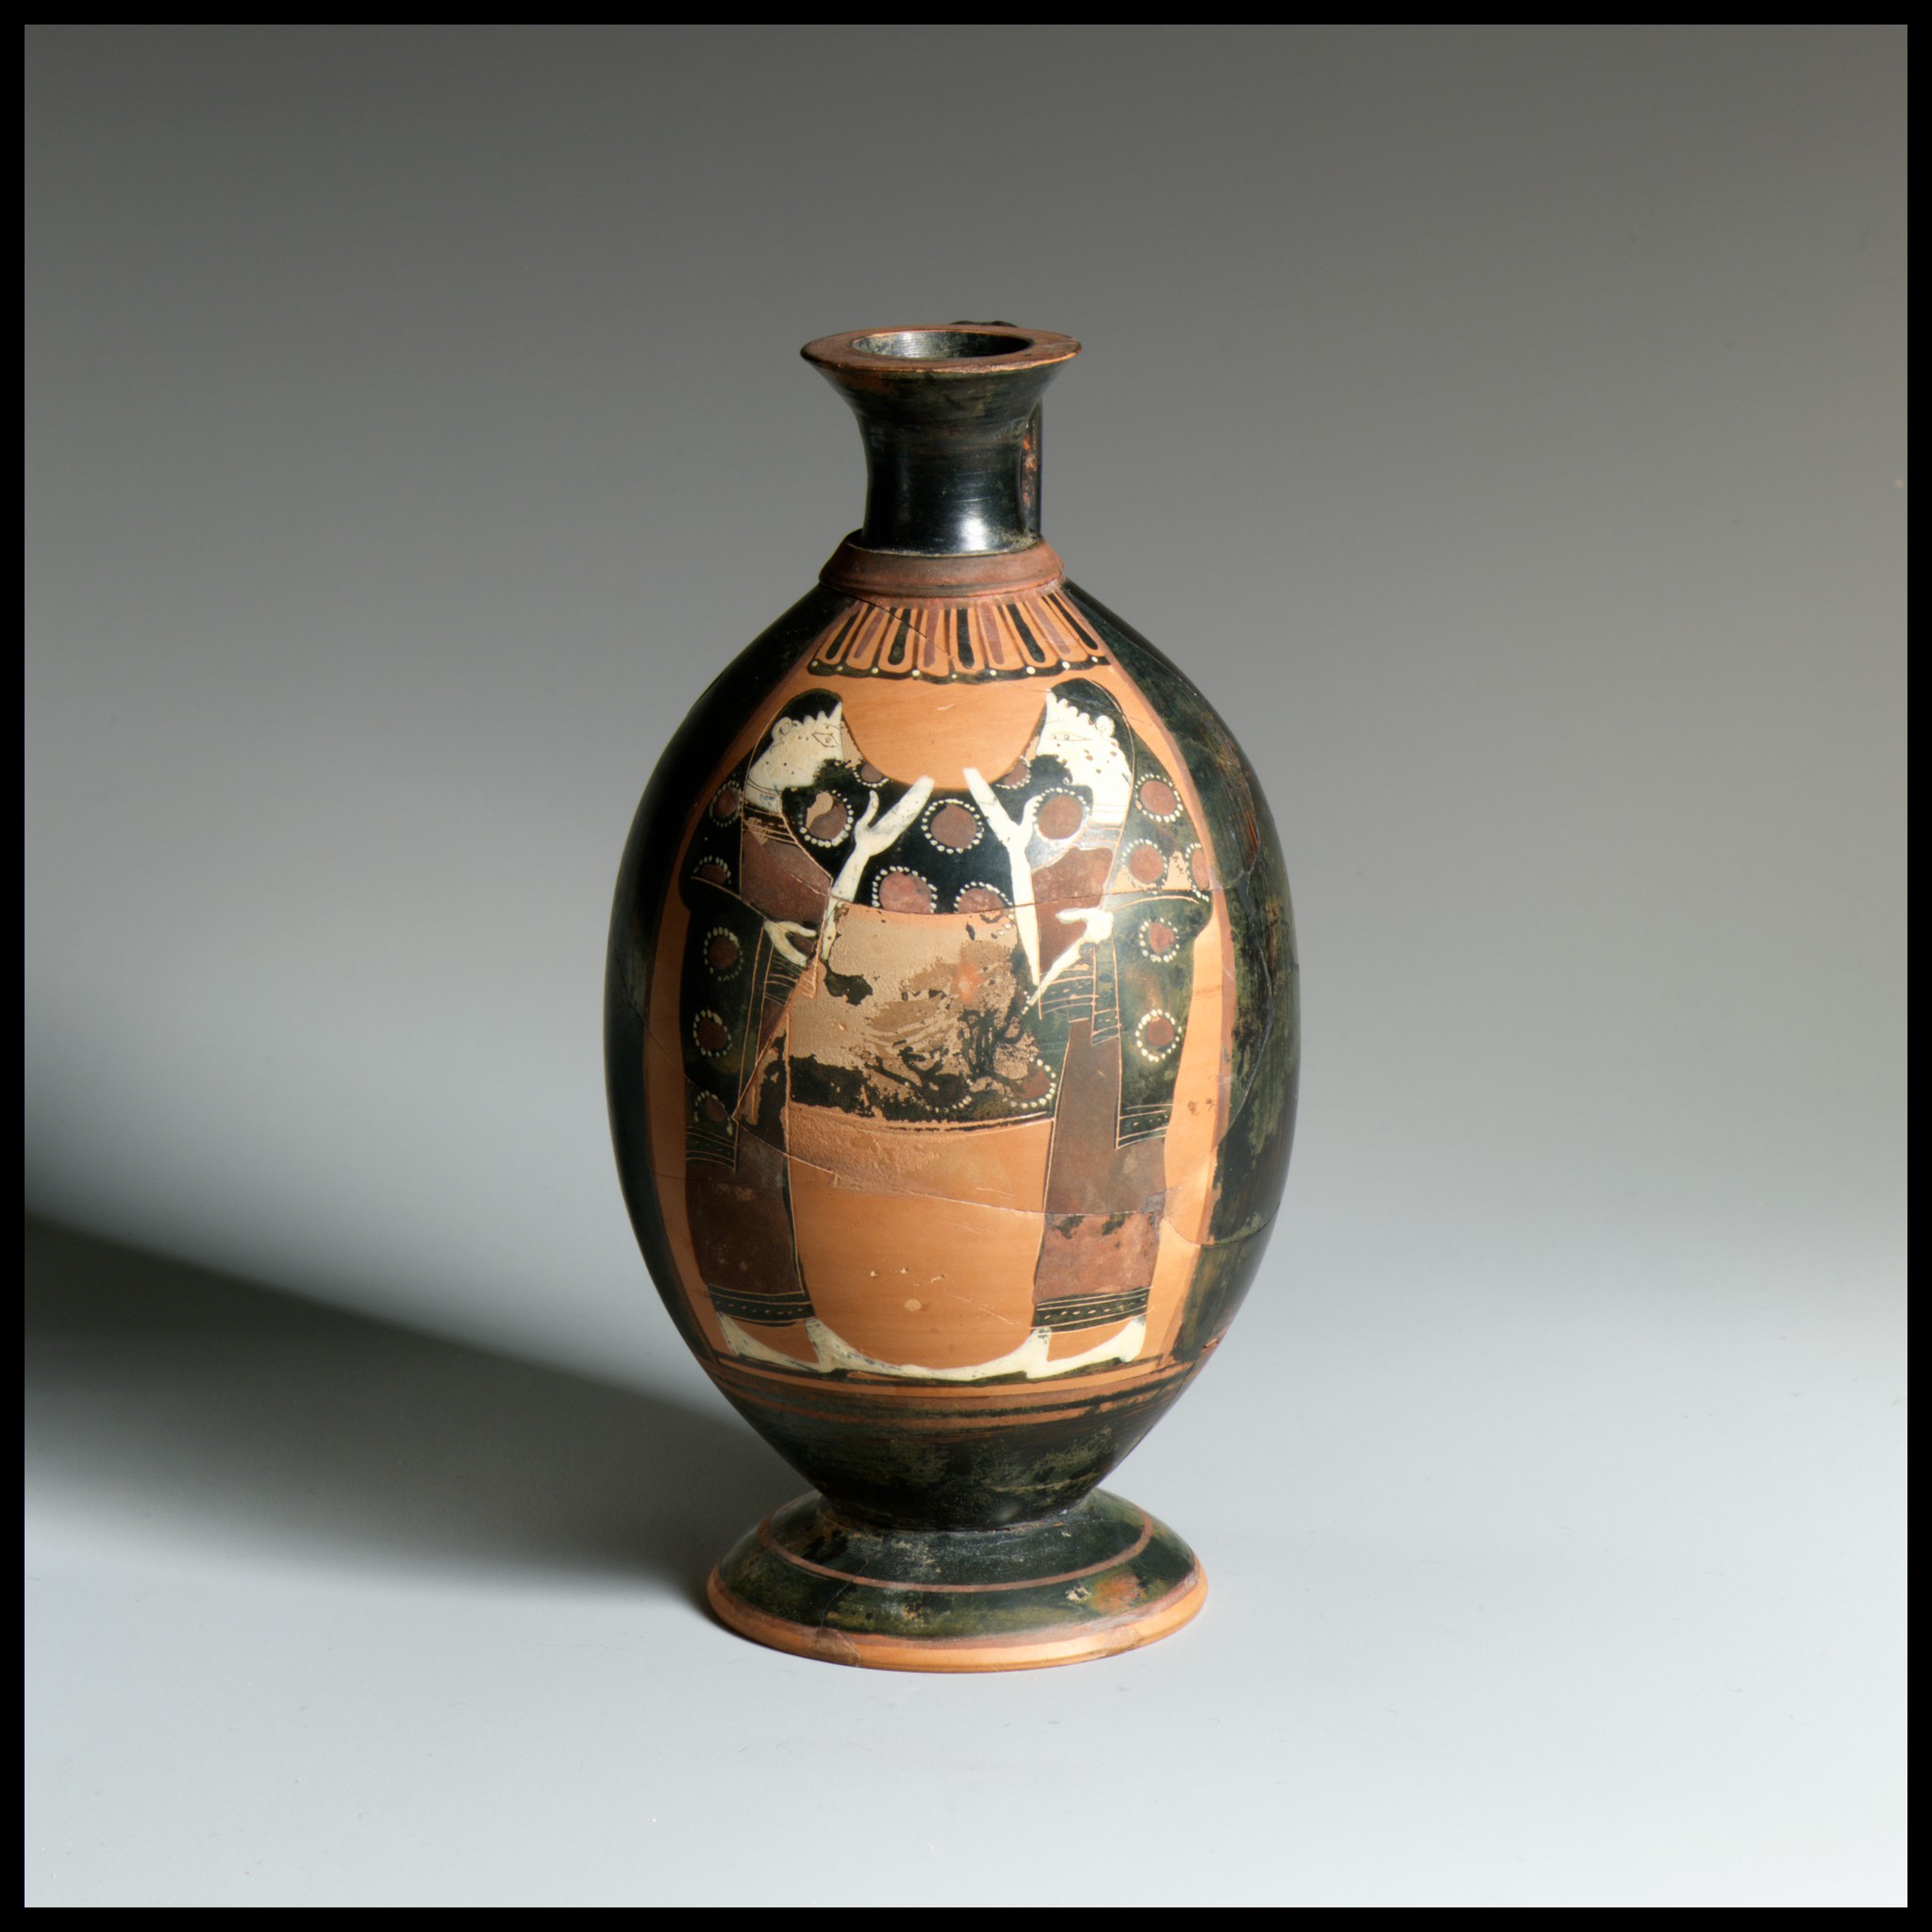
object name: lekythos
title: Terracotta lekythos (oil flask)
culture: greek, attic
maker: pharos painter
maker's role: artist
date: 550 BCE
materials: terracotta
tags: women